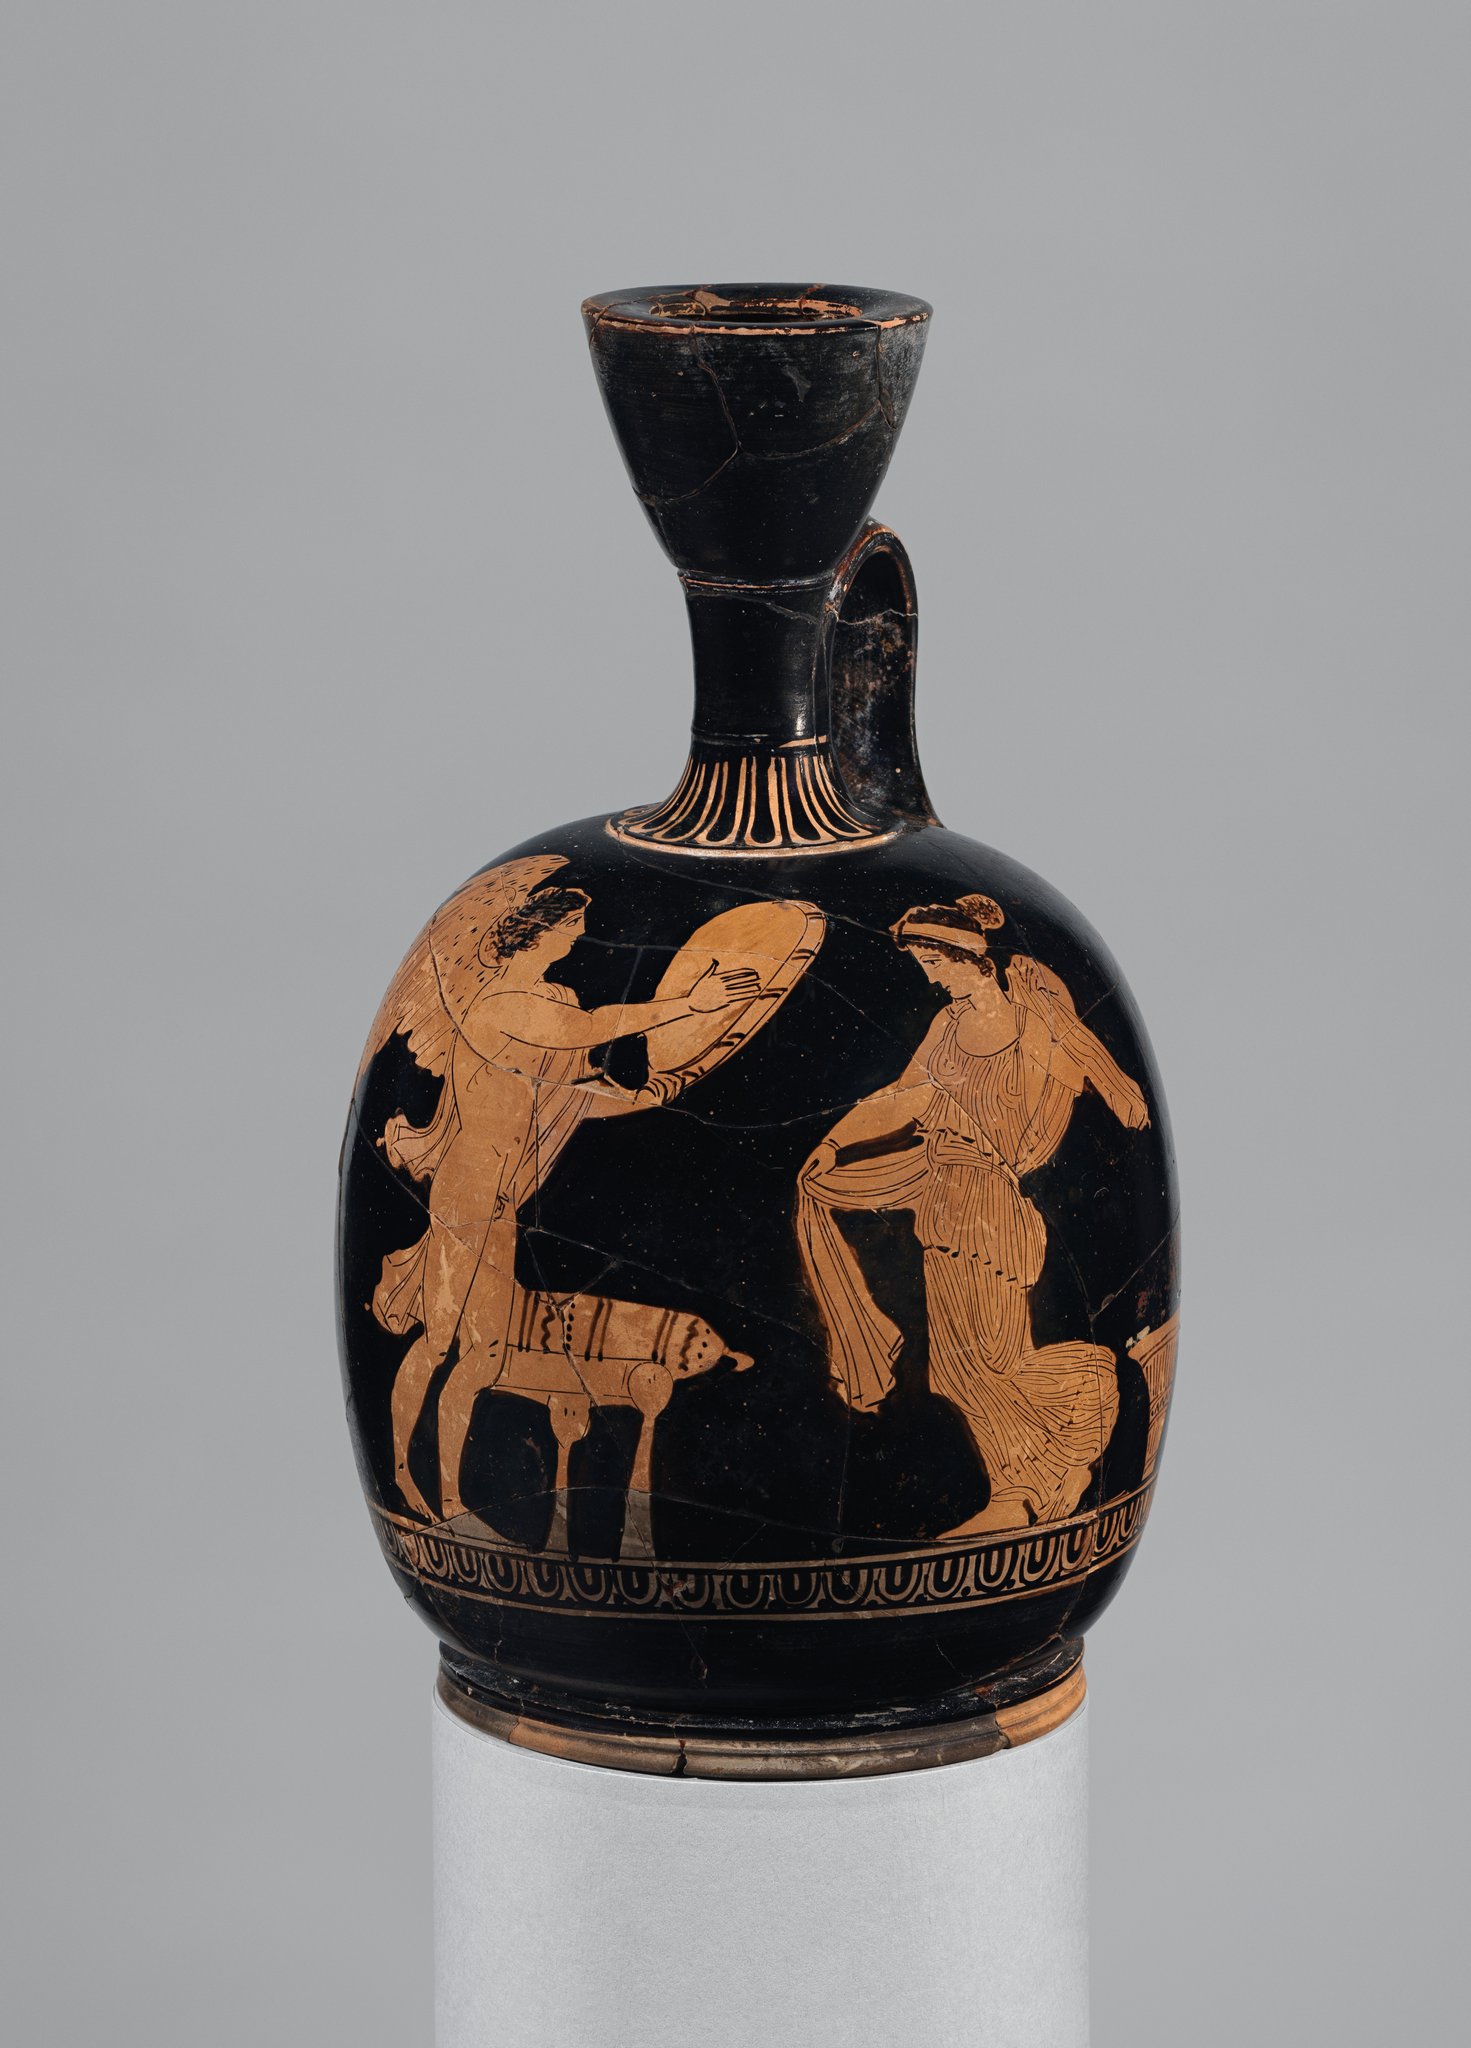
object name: squat lekythos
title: Terracotta squat lekythos (oil flask)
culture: greek, attic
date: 434-401 BCE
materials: terracotta